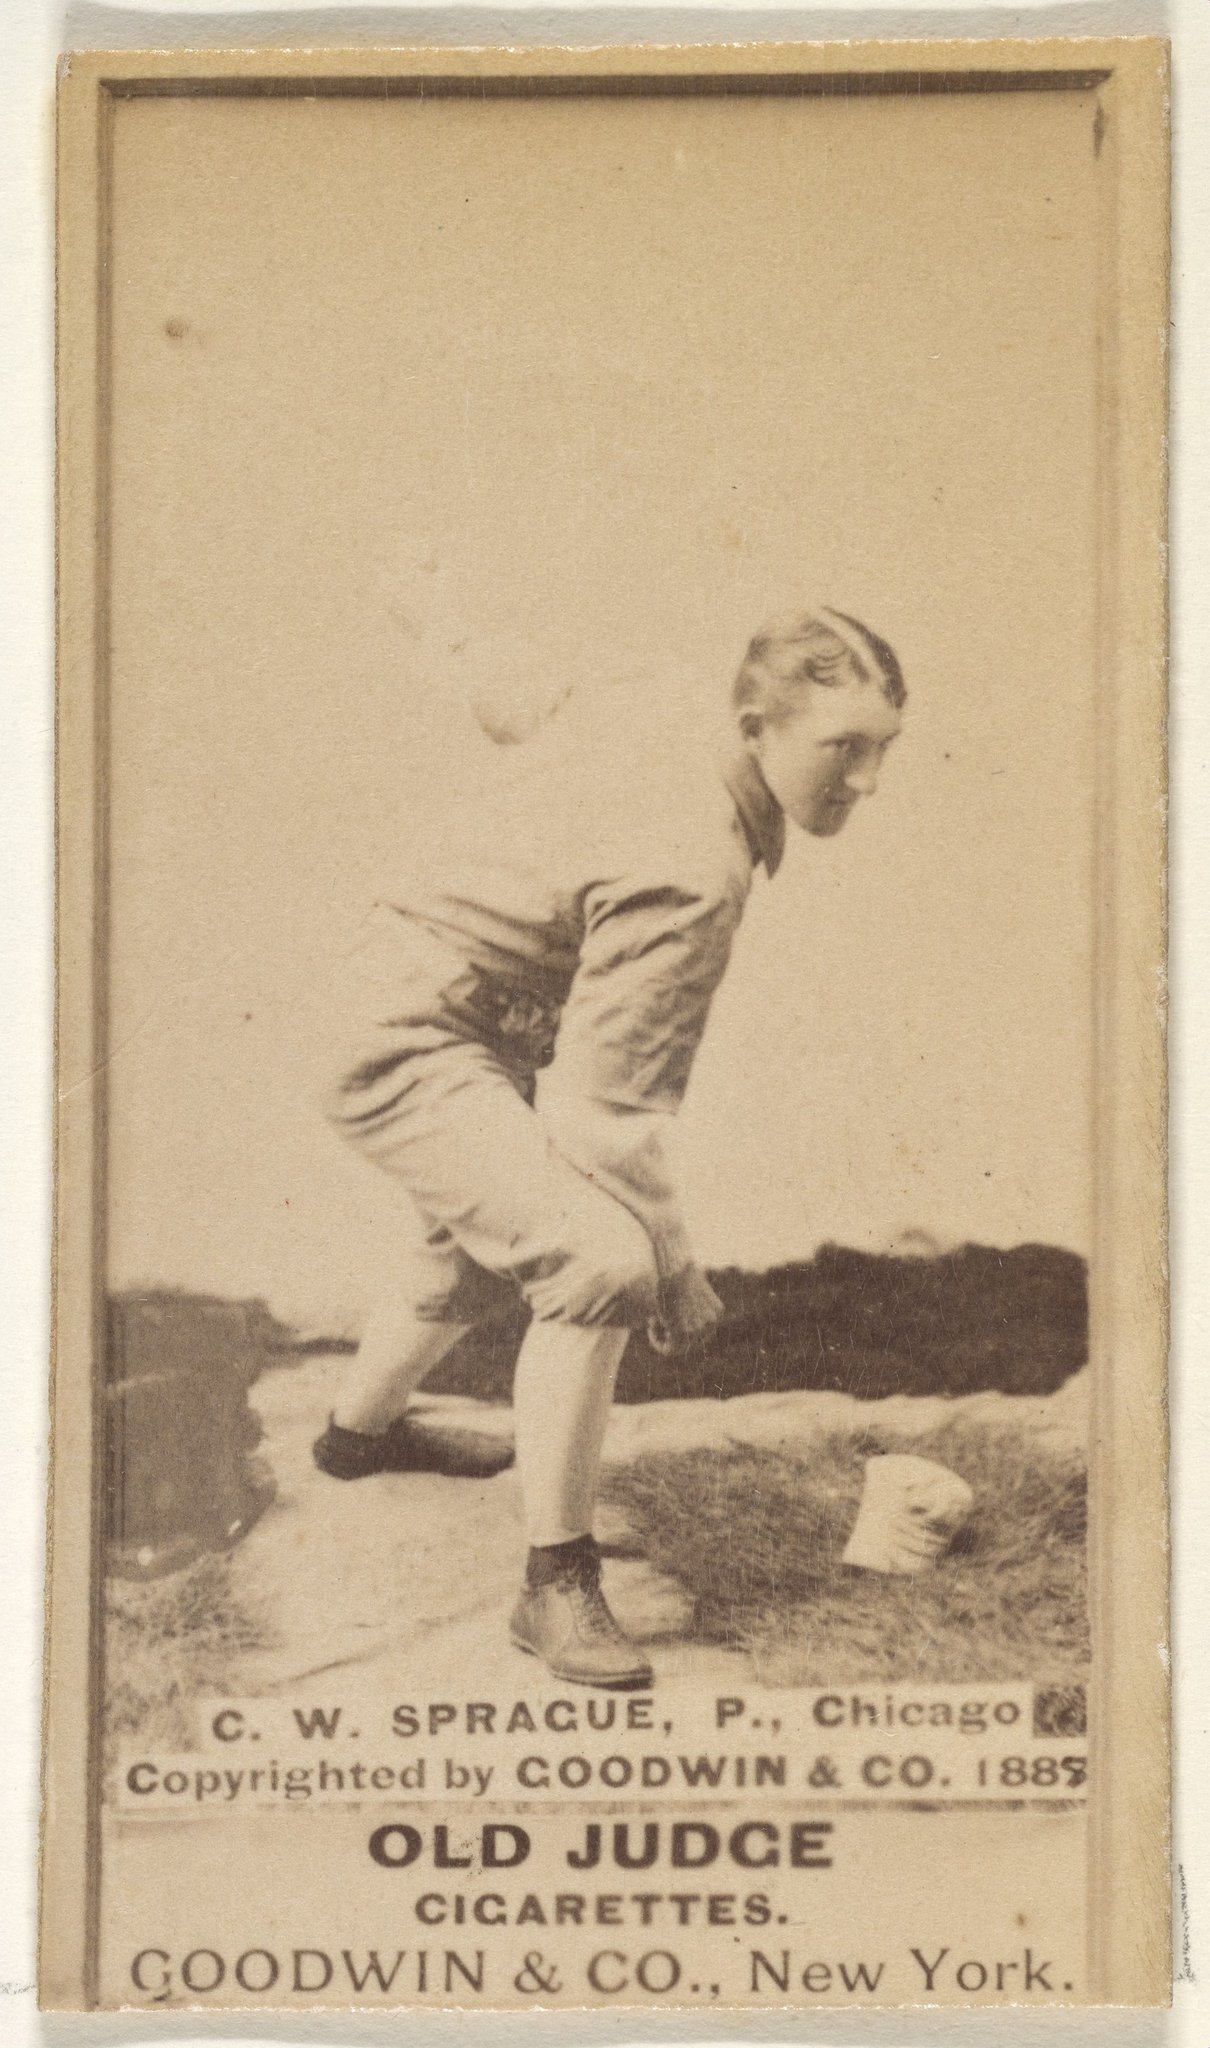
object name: baseball card, photograph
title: Sprague, Pitcher, Chicago, from the Old Judge series (N172) for Old Judge Cigarettes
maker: goodwin & company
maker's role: publisher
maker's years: 1850-1950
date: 1888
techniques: albumen silver print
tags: men,portraits,baseball,athletes